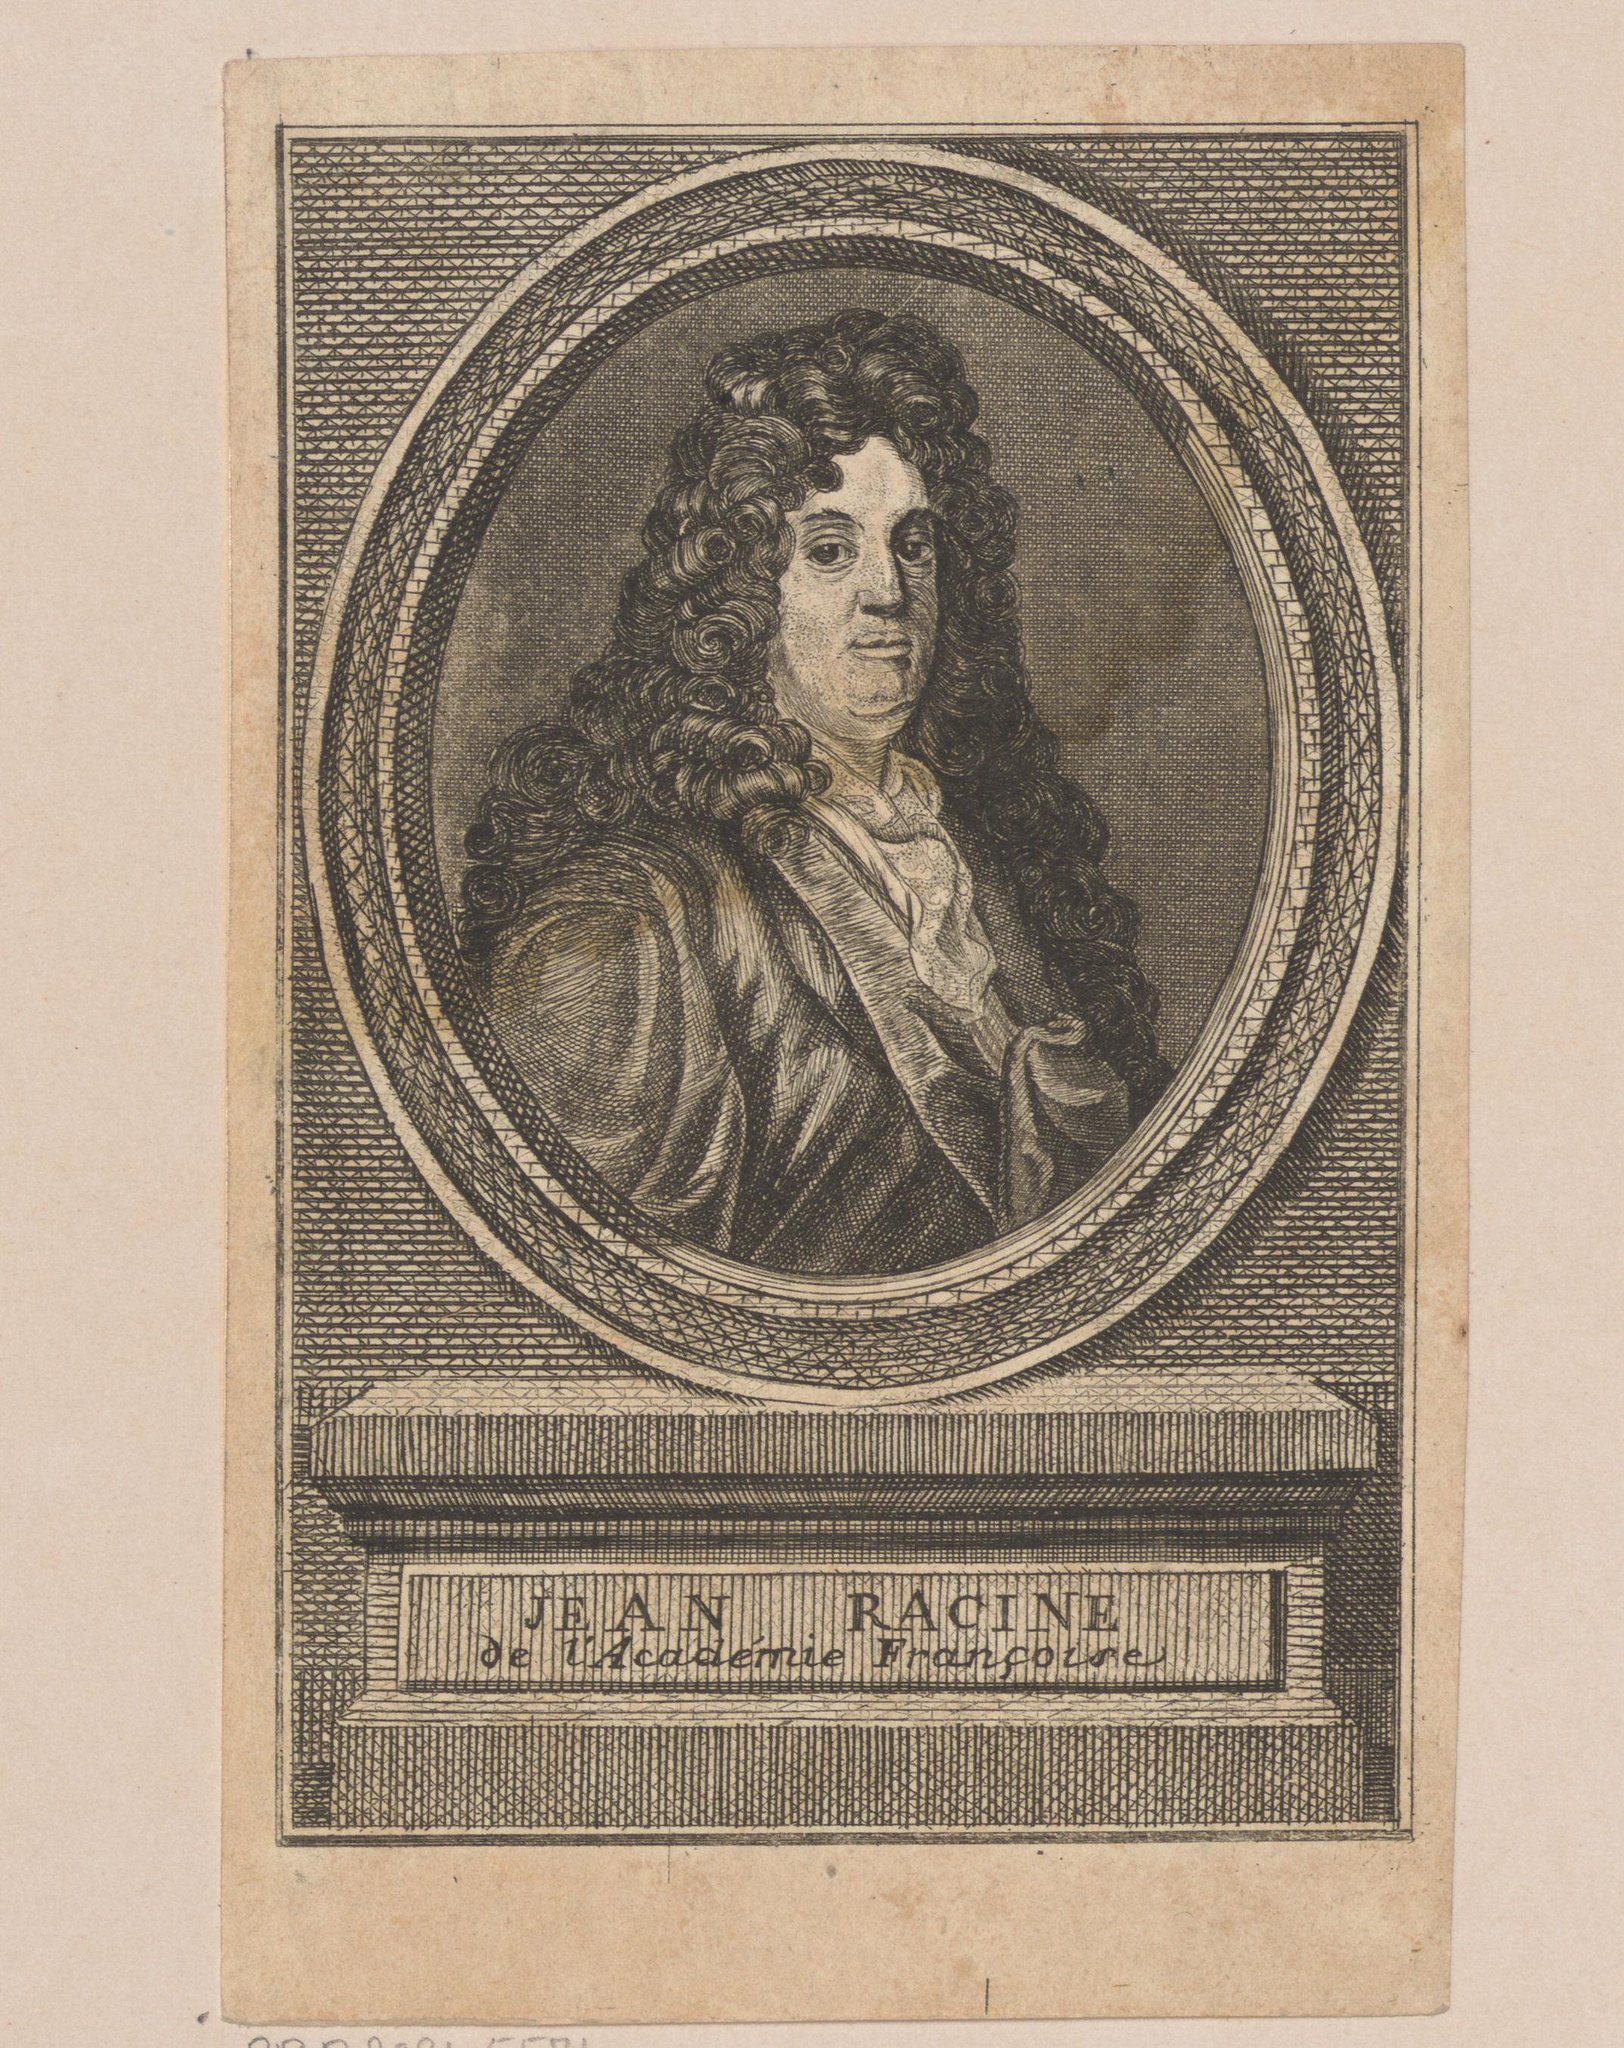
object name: print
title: Portret van Jean Racine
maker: Anonymous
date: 1769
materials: paper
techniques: engraving, etching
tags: france, paris, jean racine, historical persons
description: Prent mogelijk uit: Racine, Jean. Oeuvre de Jean Racine (...). Parijs: Compagnie des Libraires, 1769, dl. 1.